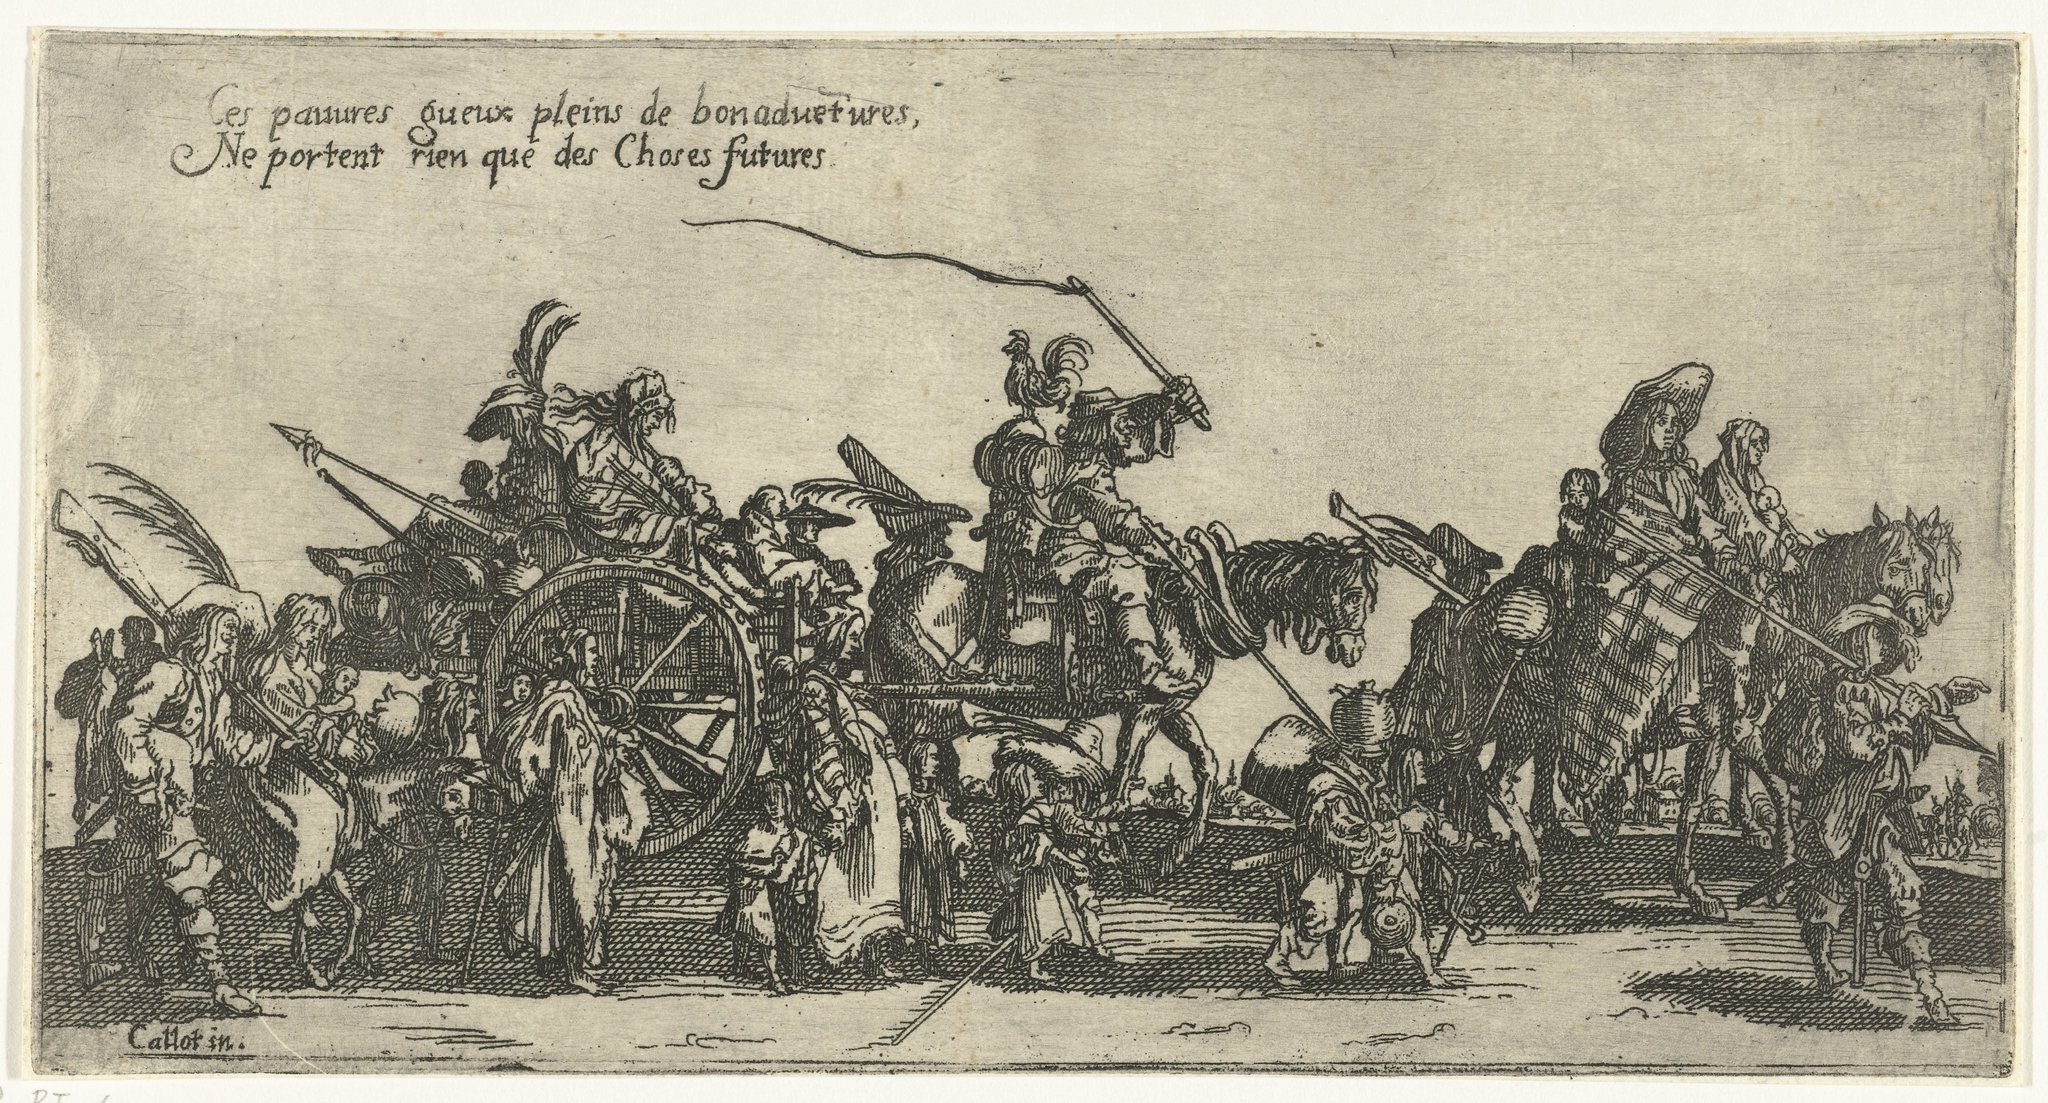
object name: print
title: Roma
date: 1603-1658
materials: paper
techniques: etching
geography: southern netherlands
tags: riding a horse, ass, or mule; rider, horseman, wandering communities: romani or roma, travelling; tourism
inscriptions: collector's mark: Lugt 2166, inscription: ‘Hoog 120, Bred 232, het [onge..] 235, n hoog 122’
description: Roma op reis. twee te paard, een met een grote kar en een met een ezel. Ze rijden in profiel van links naar rechts. De prent heeft een Frans opschrift: 'Ces pauvres gueux pleins de bonadventures, ne portent rien que des Choses futures'. Prent uit serie van vier prenten met Roma als onderwerp.